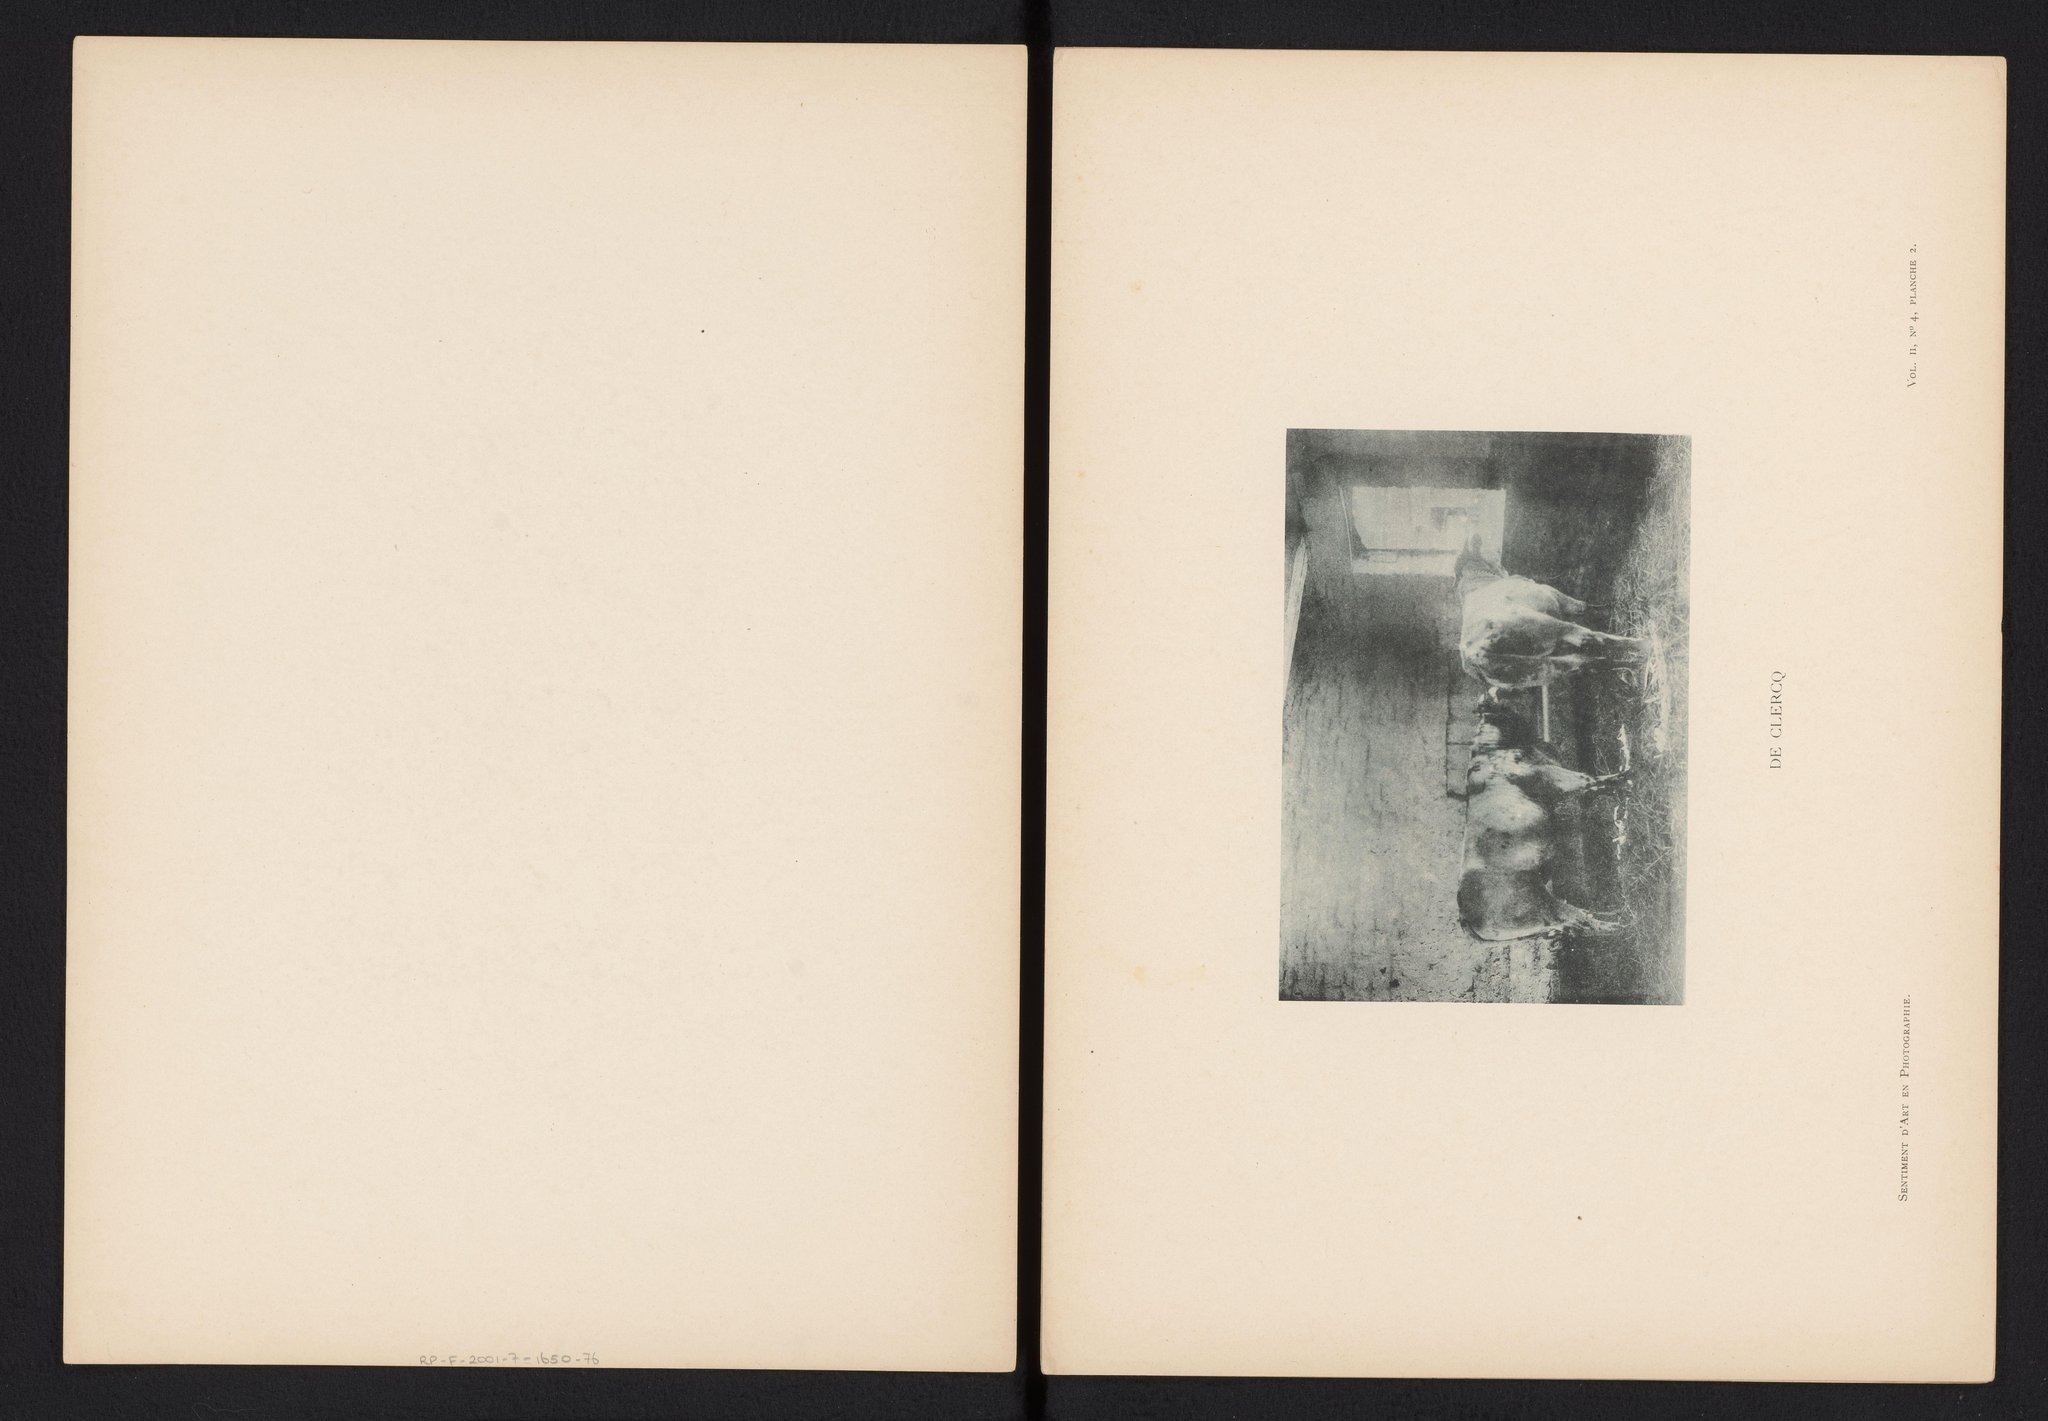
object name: photomechanical print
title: Twee koeien in een stal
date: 1895-1900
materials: paper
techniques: photograph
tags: cow, stall, stable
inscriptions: number: ‘Vol. II, No 4, Planche 2.’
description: Deze prent maakt deel uit van 8 omslagen met 22 tekstbladen en 89 prenten op losse bladen in en tussen de omslagen.